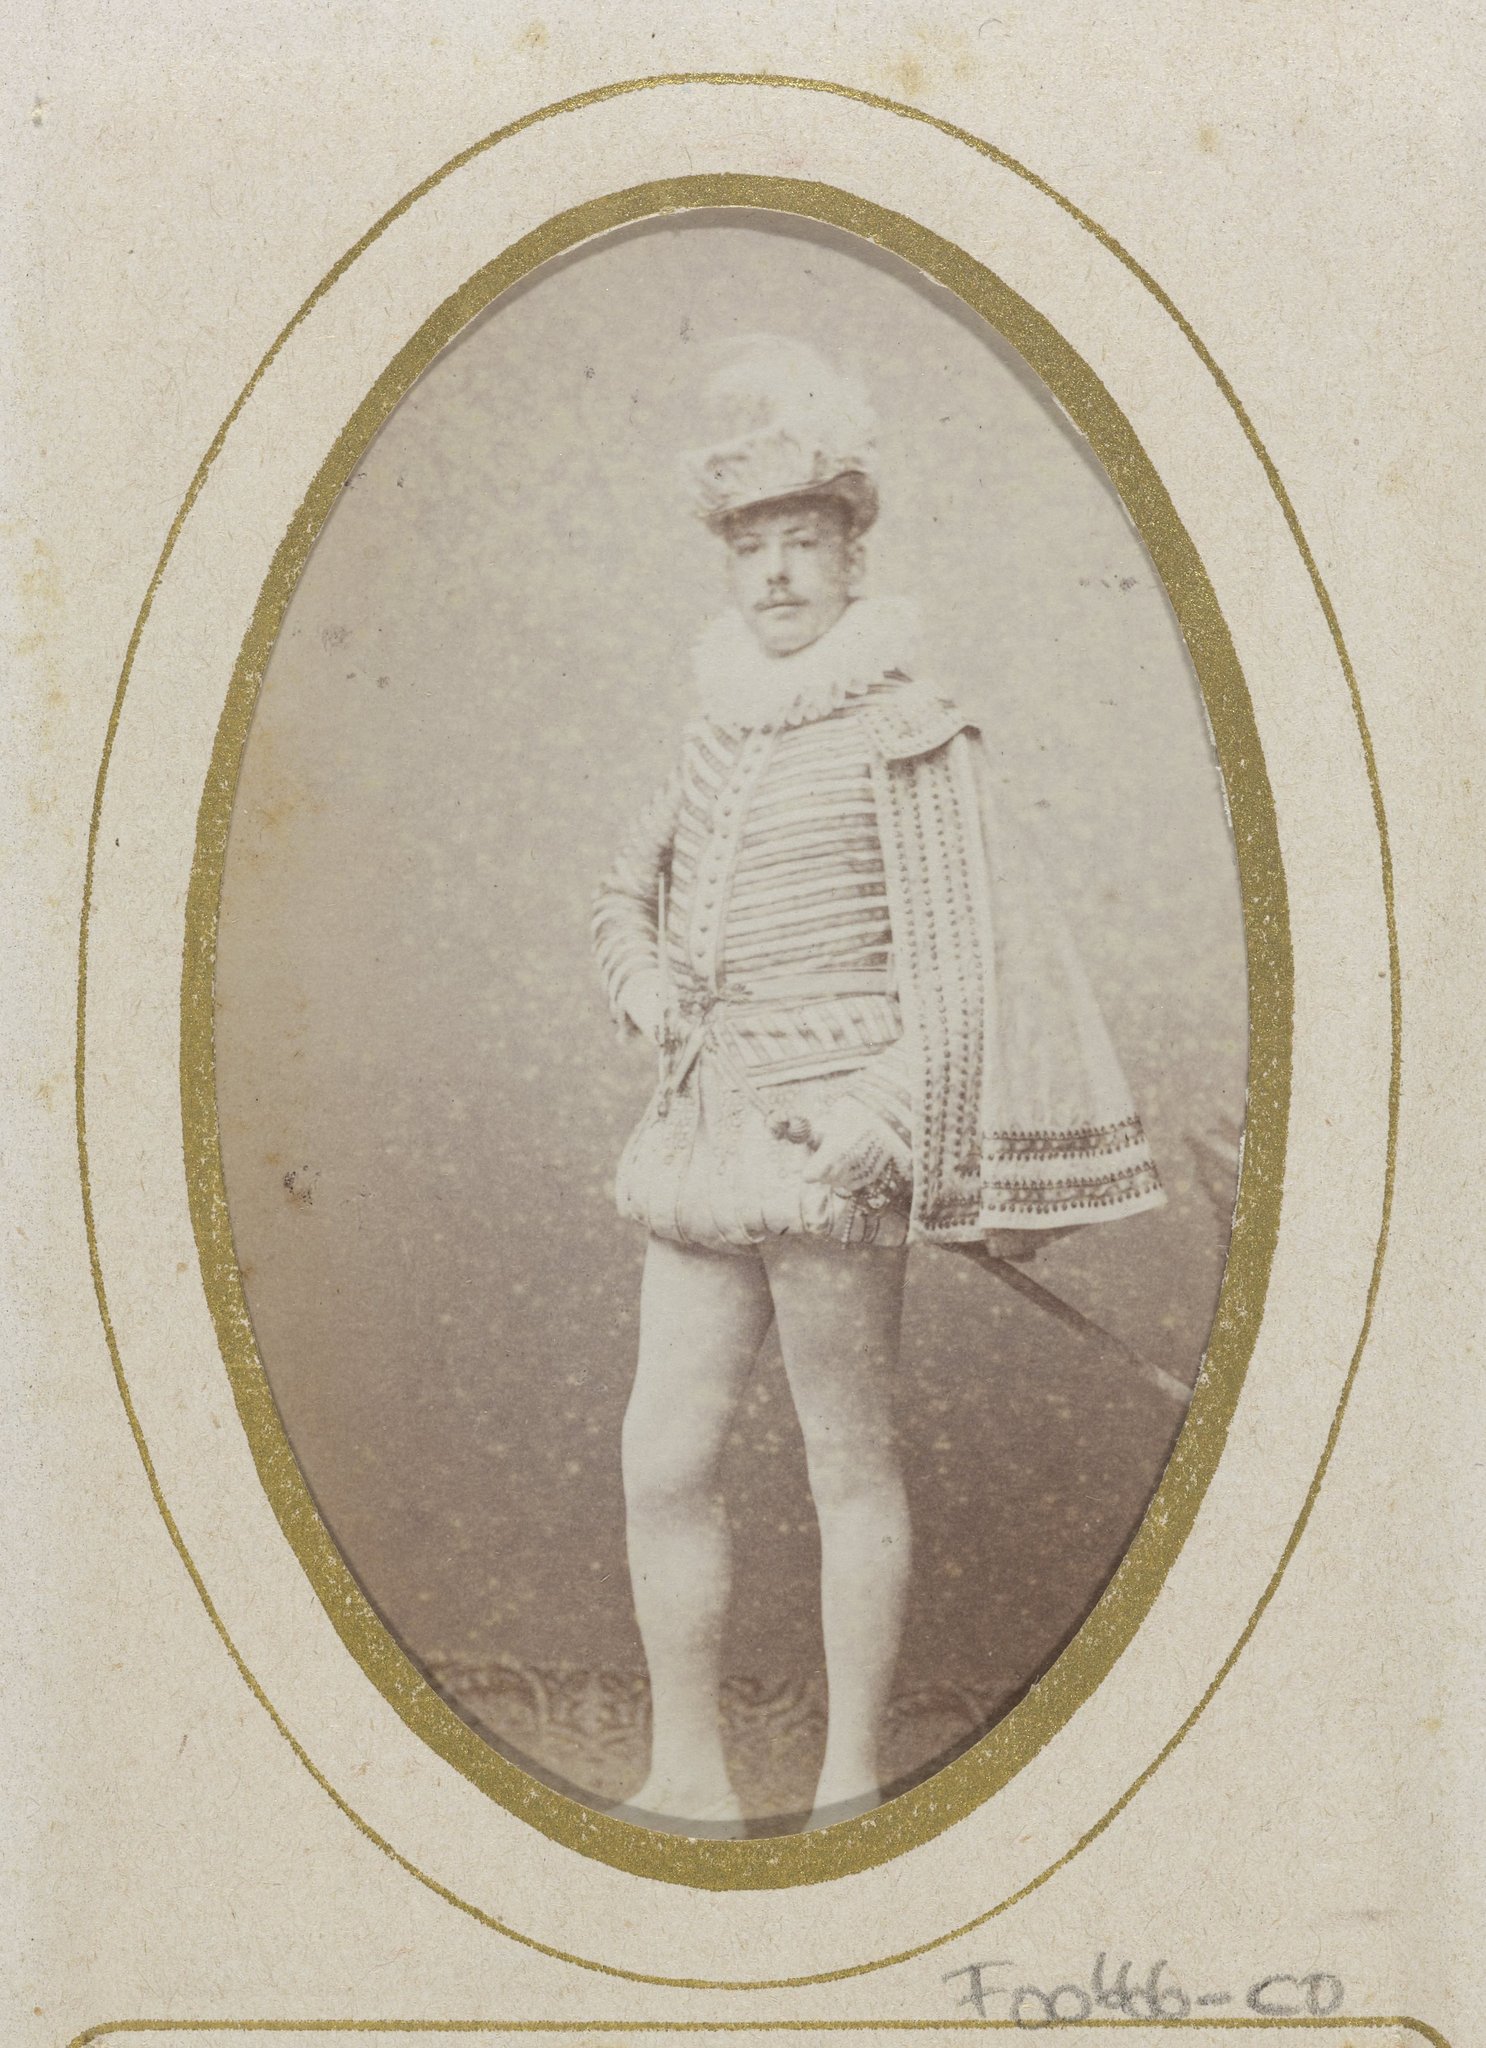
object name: photograph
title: Portret van Johan Catharinus Justus Bierens de Haan in kostuum met degen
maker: jan goedeljee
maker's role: fotograaf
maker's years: 1824-1905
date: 1885-1895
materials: cardboard, photographic support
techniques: albumen print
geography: leiden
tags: leiden, amsterdam, historical persons, historical costume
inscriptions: inscription: ‘J. Goedeljee/ Photograaf/ Z. K. H. PRINS ALEXANDER/ der Nederlanden/ PRINS van ORANJE/ en H. K. H./ PRINSES HENDRIK/ der Nederlanden/ Hoogewoerd 160/ nabij de Plantage.’, name: ‘J. C. J. Bierens de Haan./ 175.’